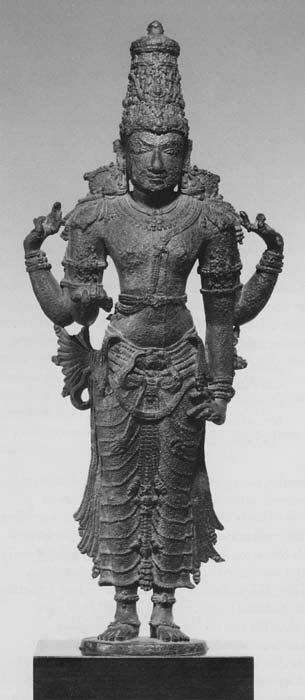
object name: figure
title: Standing Vishnu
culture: indian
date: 967-1100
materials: bronze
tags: vishnu